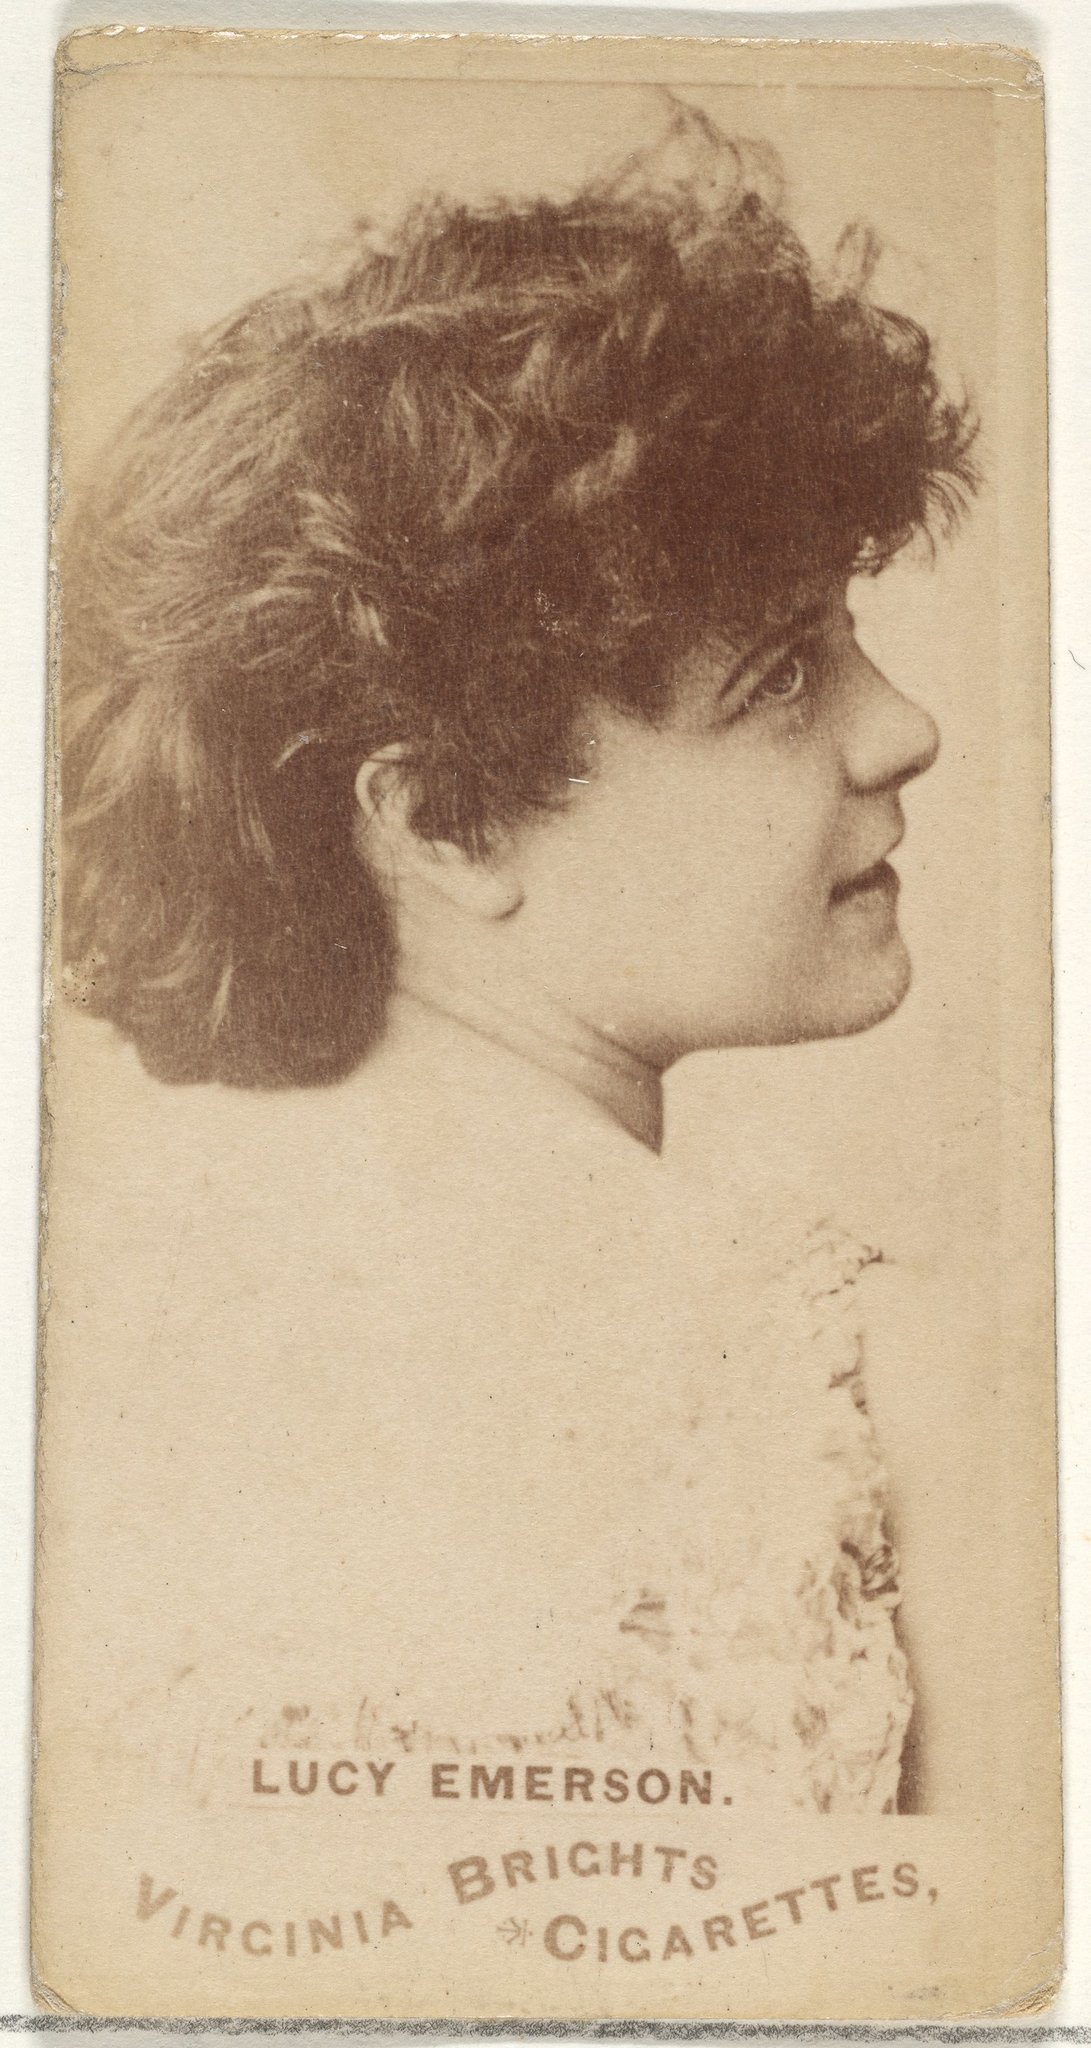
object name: photograph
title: Lucy Emerson, from the Actors and Actresses series (N45, Type 1) for Virginia Brights Cigarettes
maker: allen & ginter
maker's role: publisher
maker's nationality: american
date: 1888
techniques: albumen silver print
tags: portraits,profiles,women,actresses